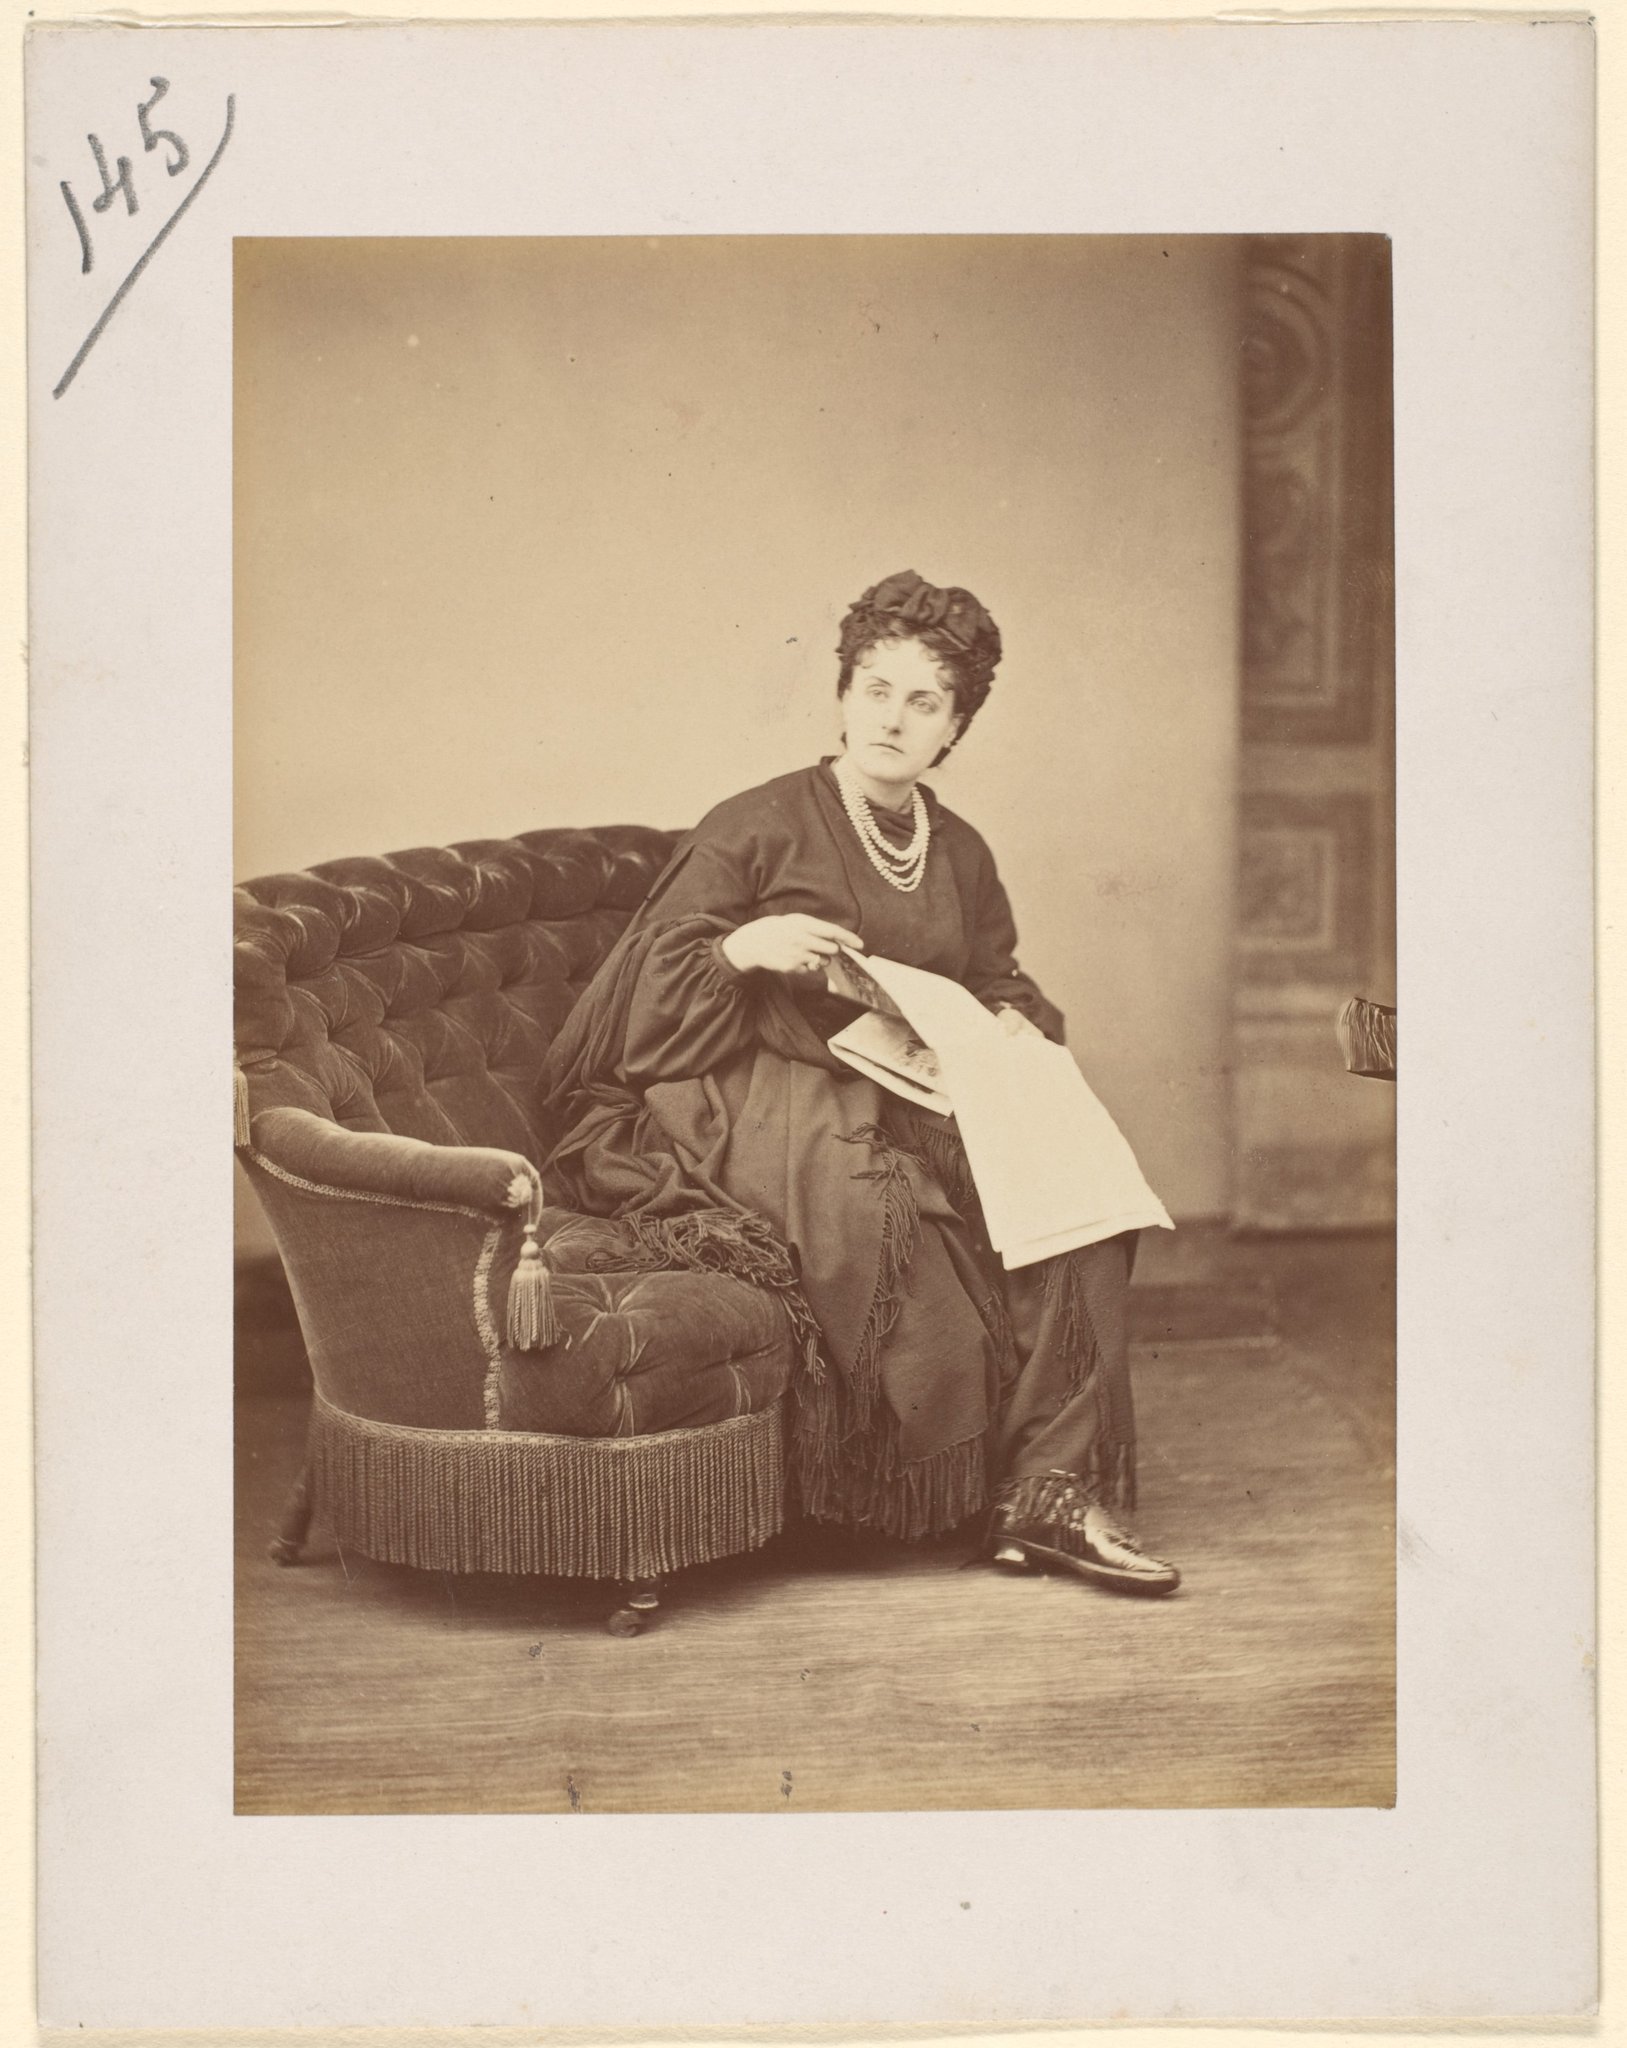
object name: photograph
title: Sèriè à la Ristori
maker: pierre-louis pierson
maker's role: artist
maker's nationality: french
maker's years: 1822-1913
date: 1860-1869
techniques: albumen silver print, glass negative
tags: portraits,women